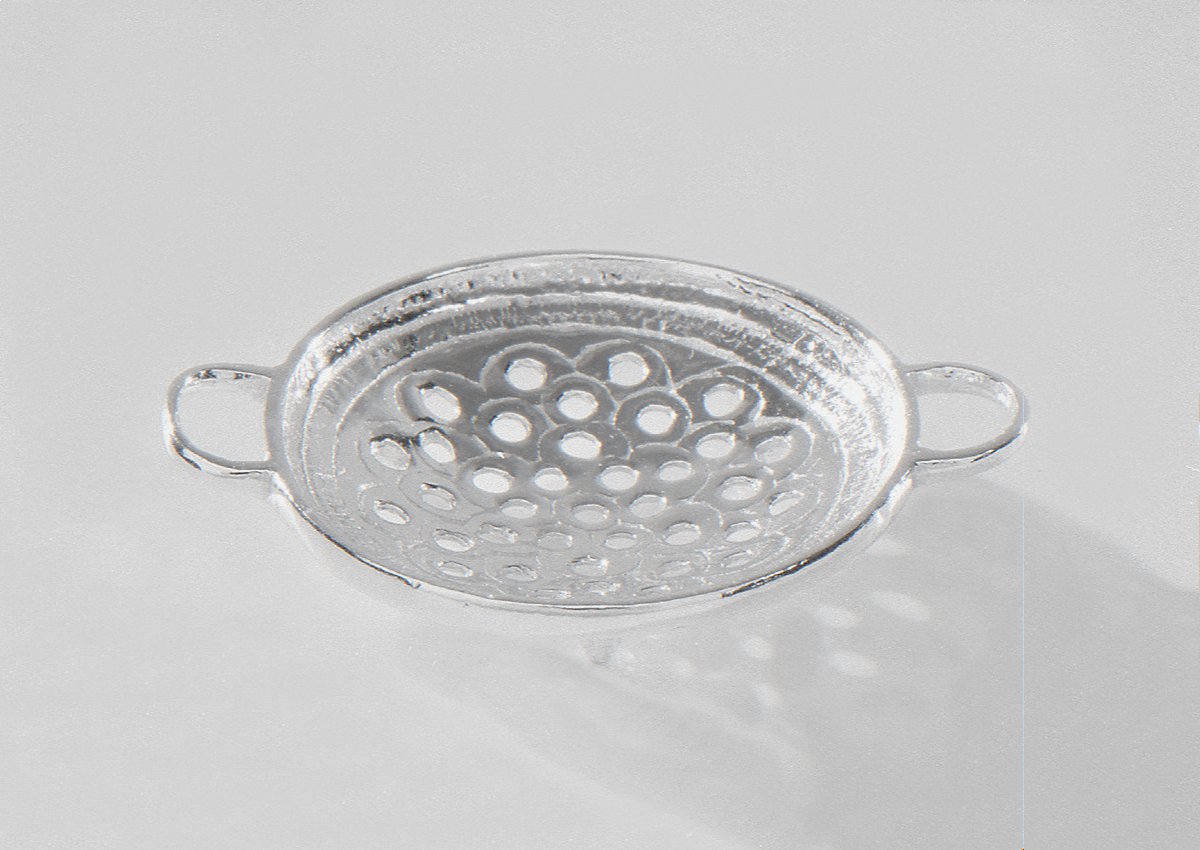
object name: miniature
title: Vergiet (gatenpetiel)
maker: Anonymous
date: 1700-1800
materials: silver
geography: netherlands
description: Gatenpateel op drie poten en met twee horizontale handvatten. Rond de gaten in het pateel zijn lijnen gegraveerd. Langs de rand zijn concentrische lijnen gegraveerd. Het gatenpateel is gemerkt met een onleesbaar merk.